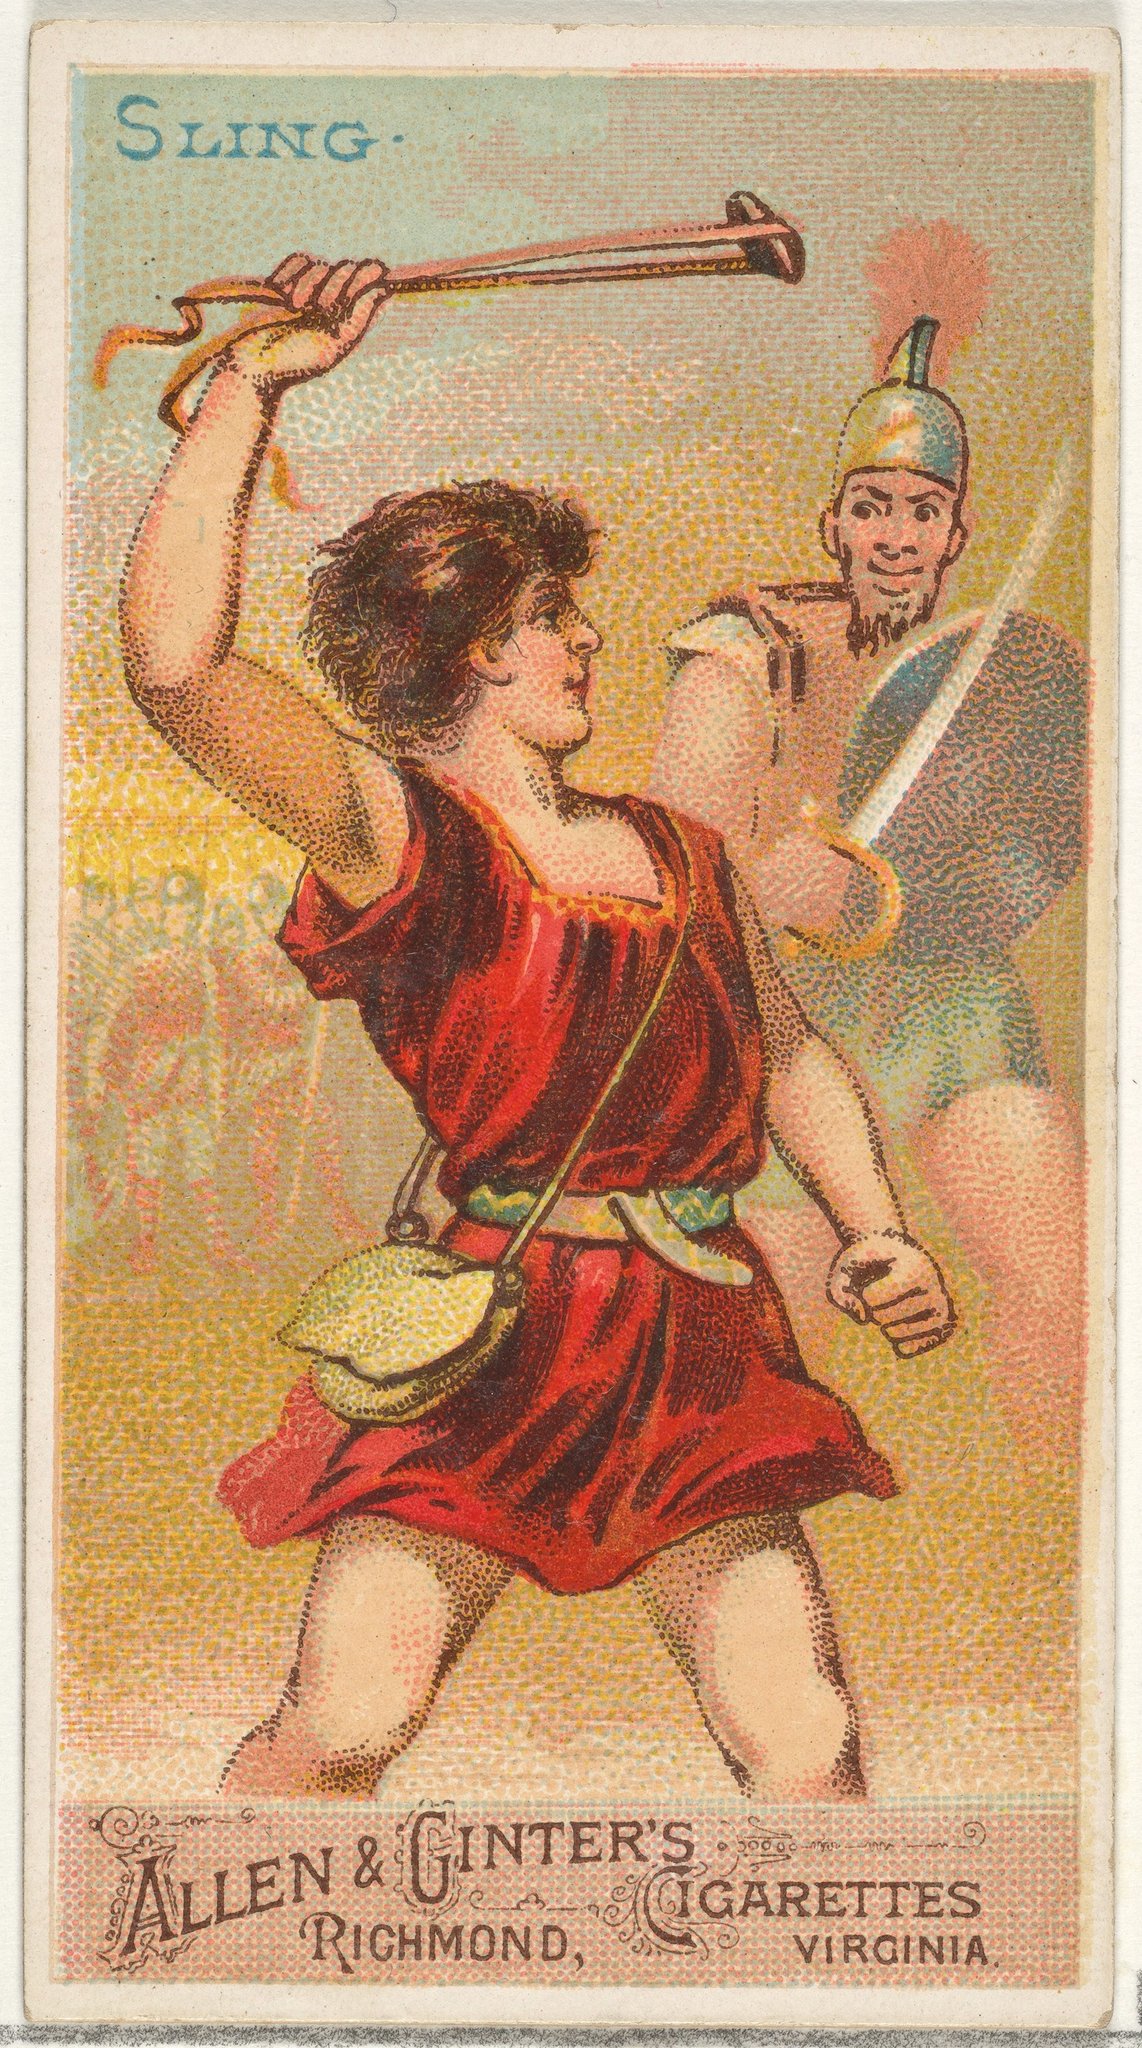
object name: print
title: Sling, from the Arms of All Nations series (N3) for Allen & Ginter Cigarettes Brands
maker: allen & ginter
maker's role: publisher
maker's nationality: american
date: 1887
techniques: color lithograph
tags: shields,swords,men